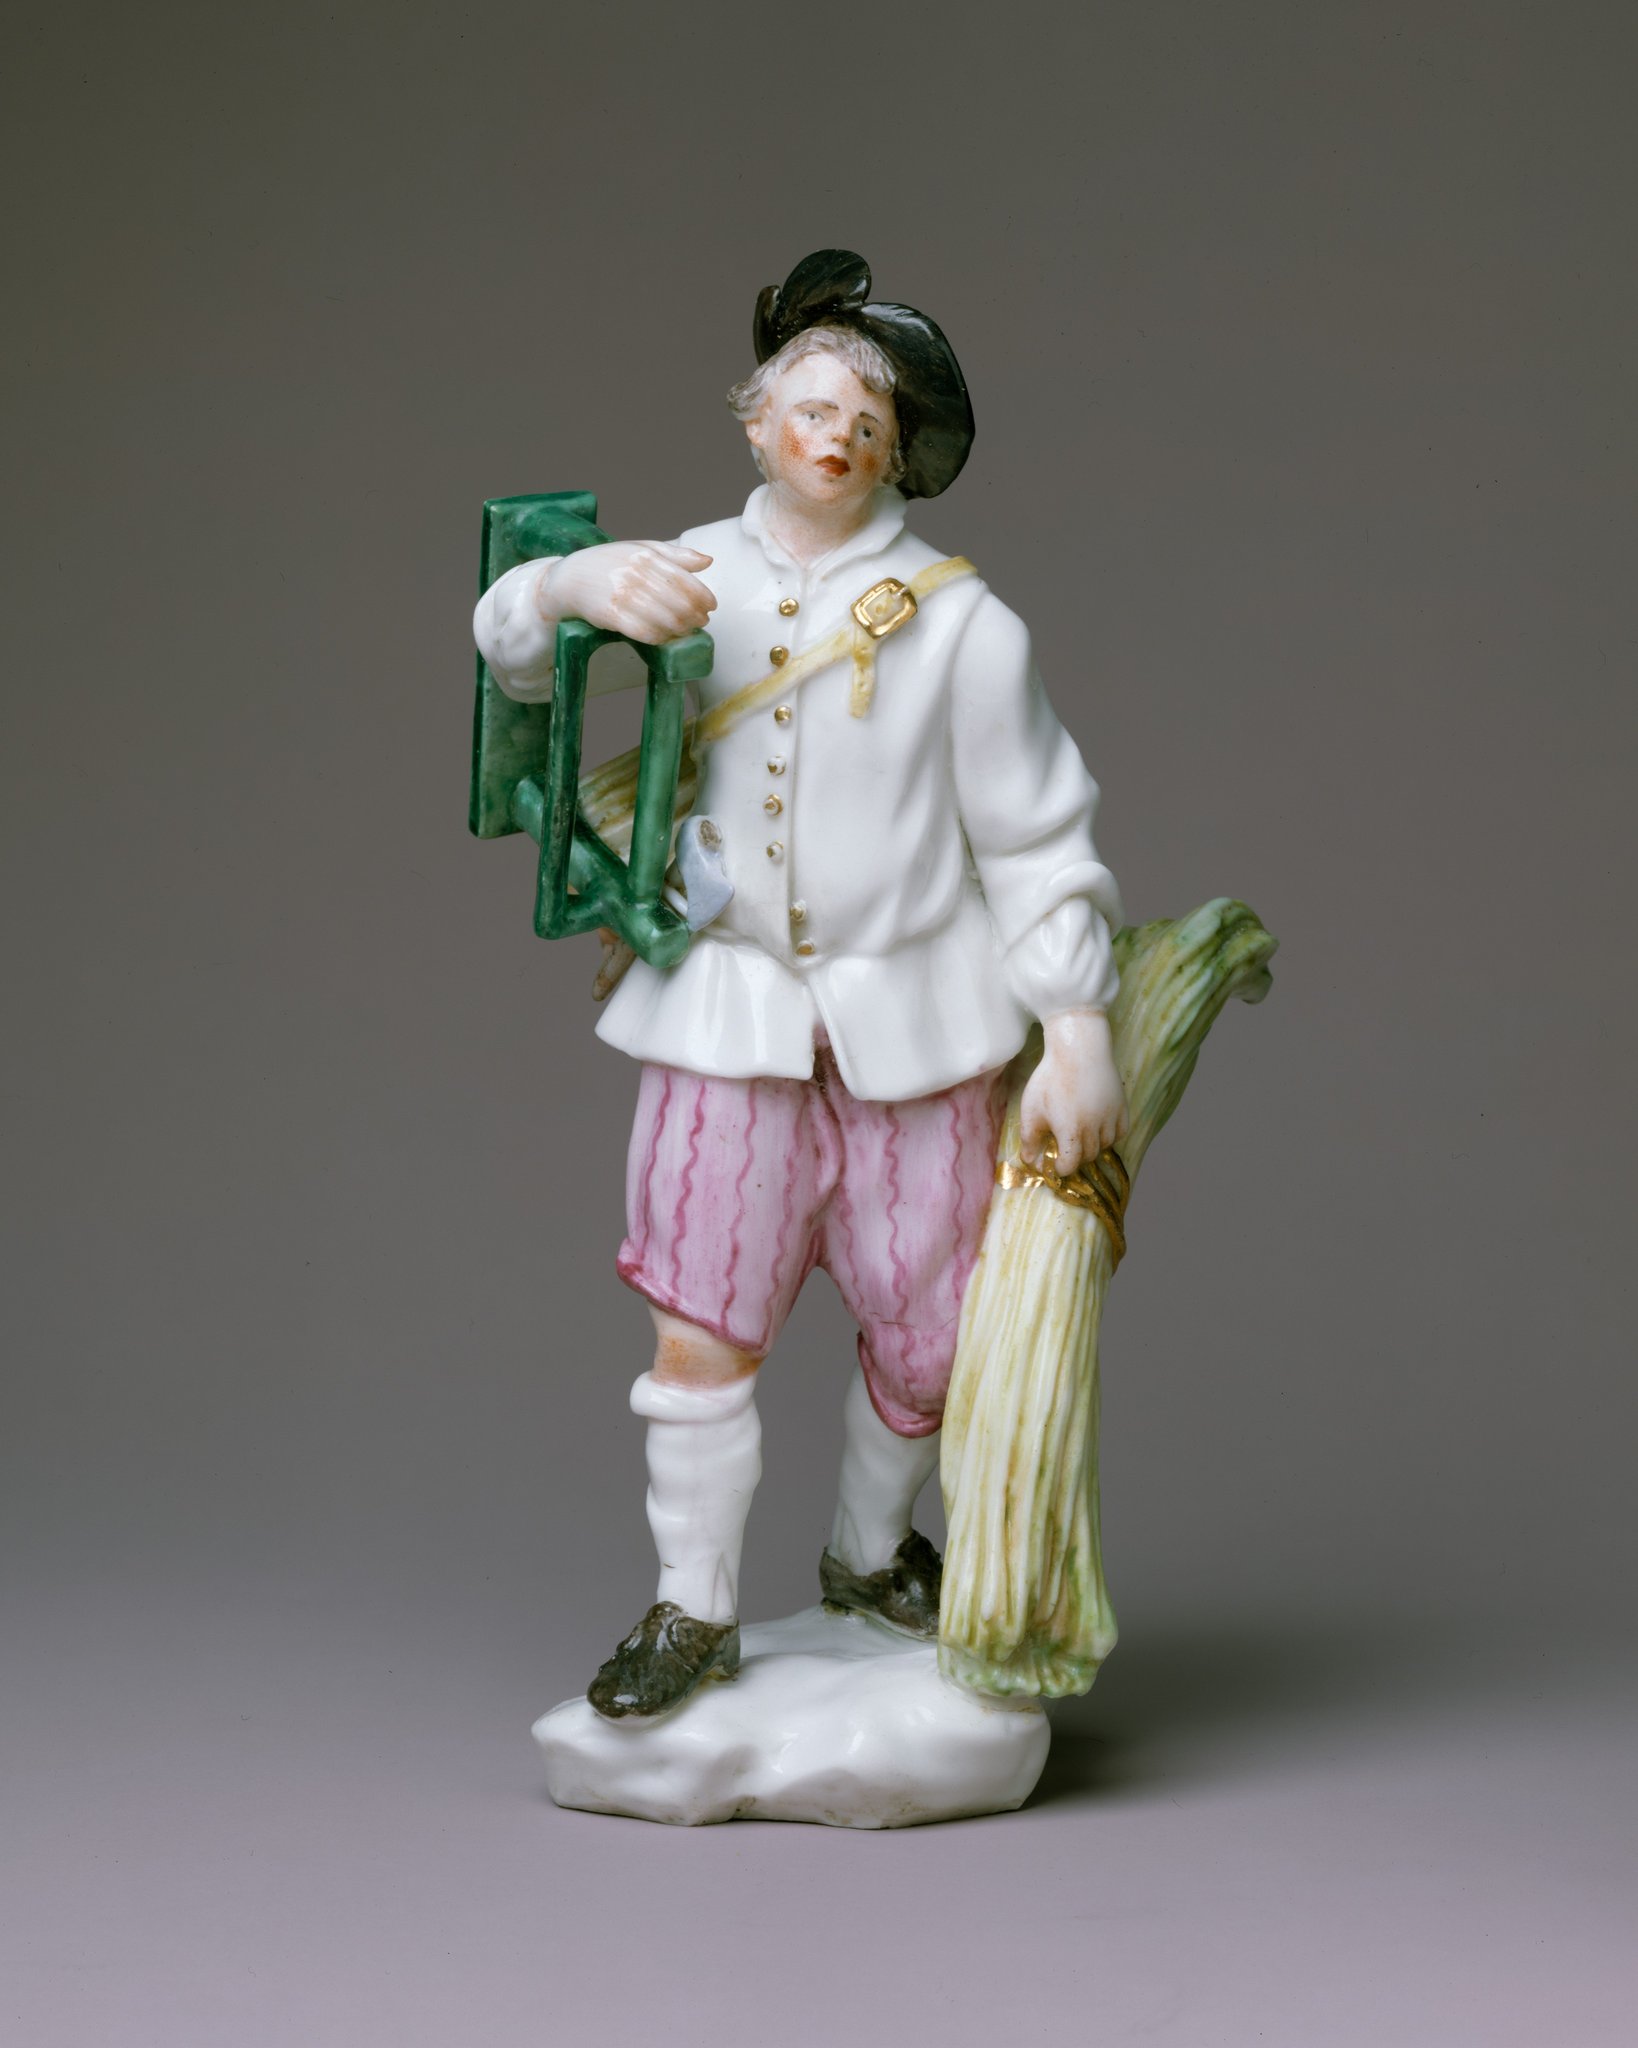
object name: figure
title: Chairmaker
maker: capodimonte porcelain manufactory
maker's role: manufactory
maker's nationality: italian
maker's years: 1740-1759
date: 1755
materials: soft paste porcelain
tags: men